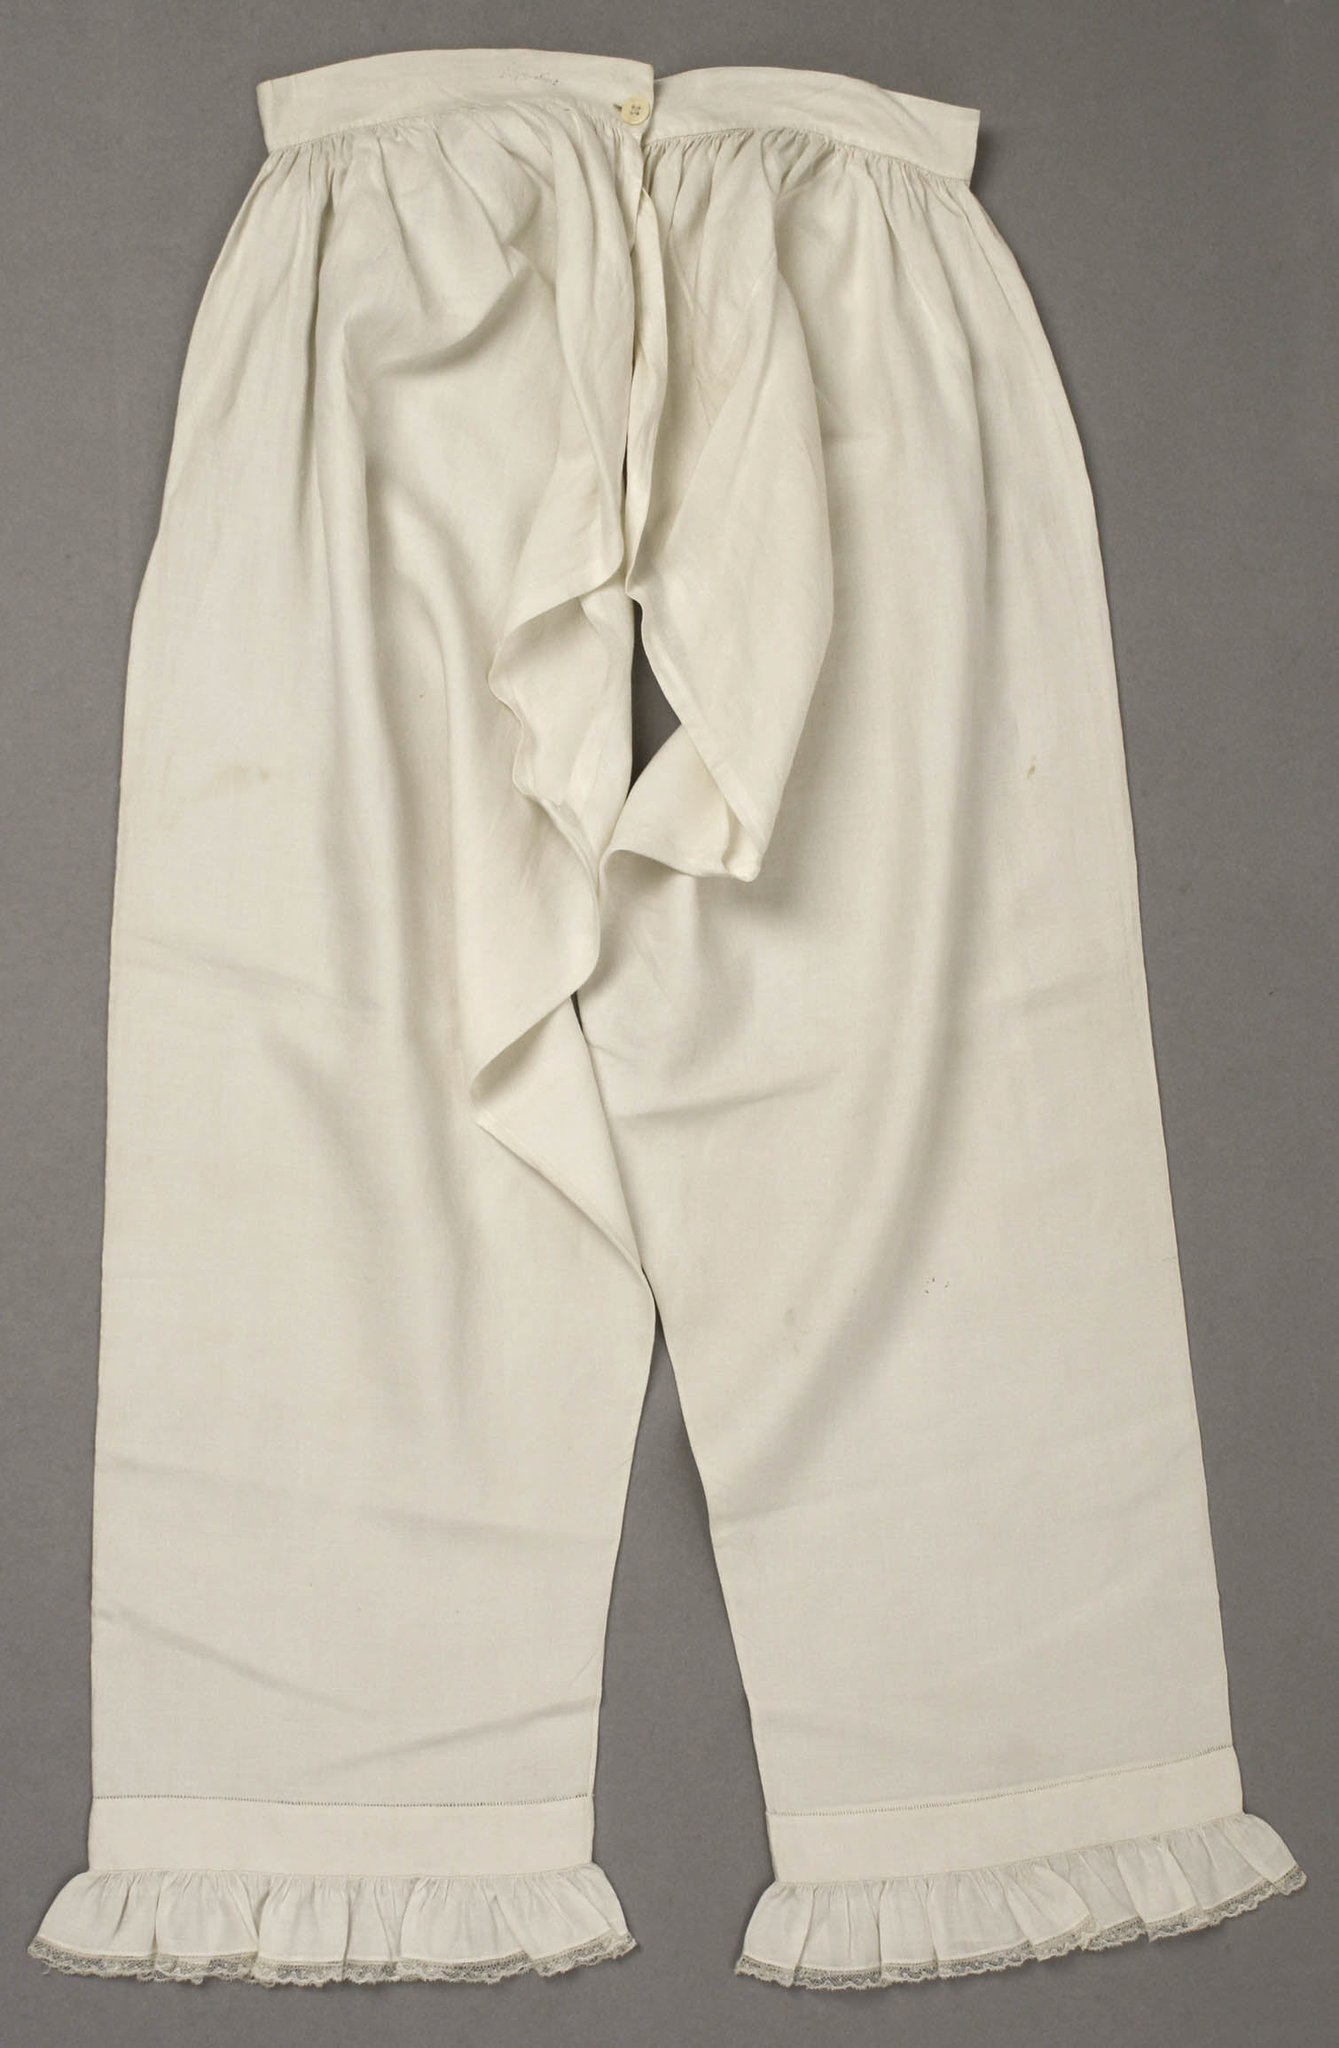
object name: pantalets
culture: american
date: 1830-1839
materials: linen